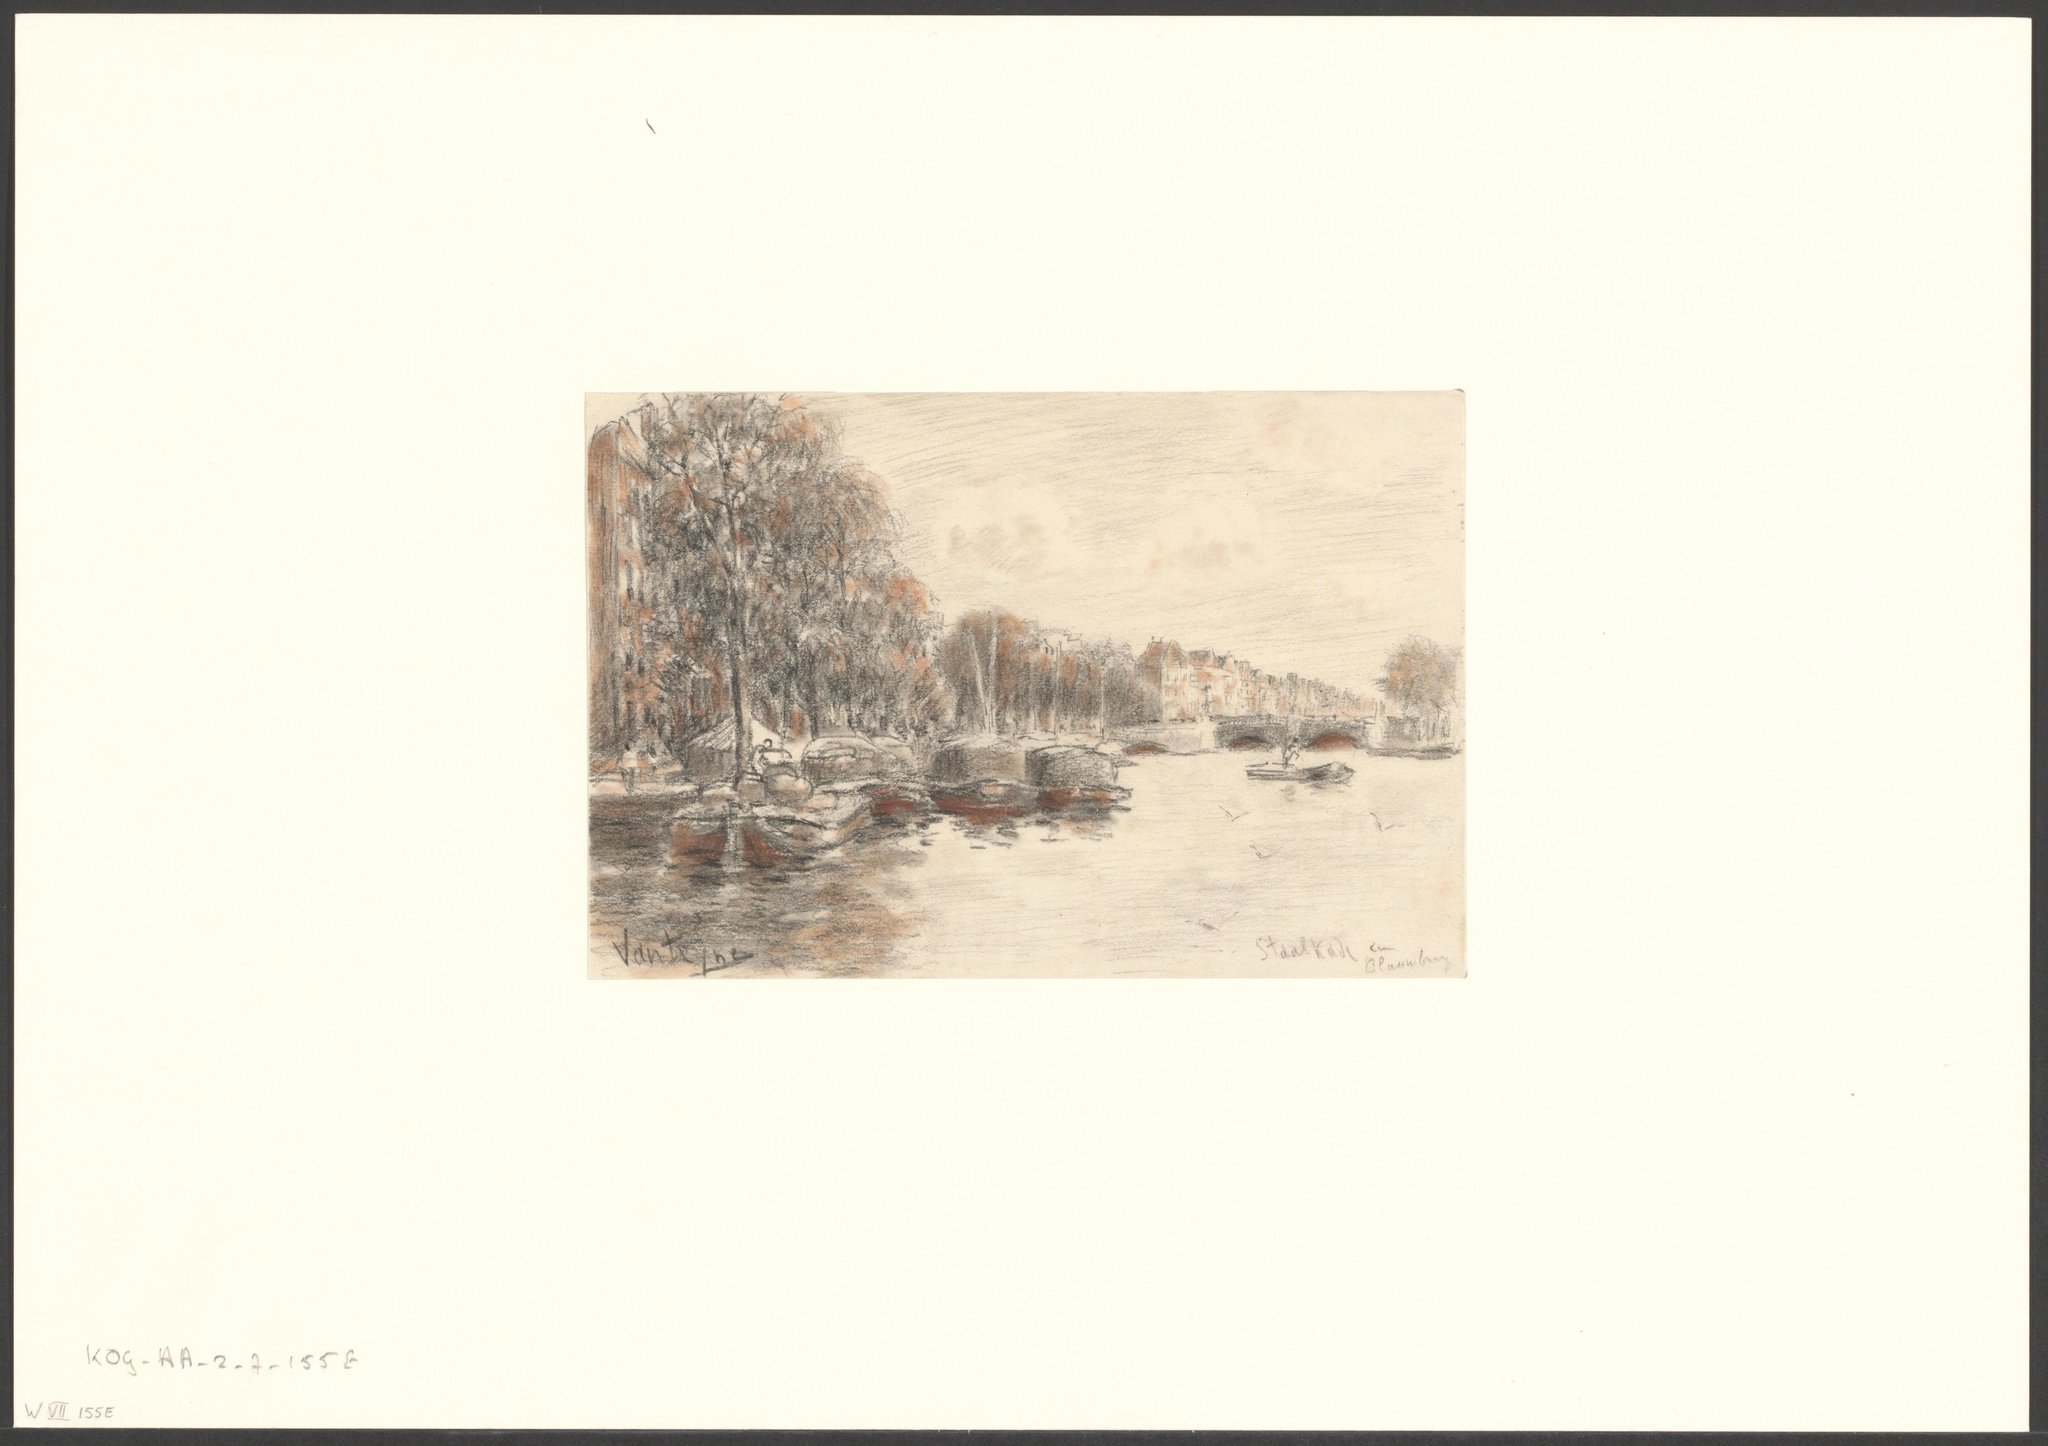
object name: drawing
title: Gezicht op de Amstel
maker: anthonie van teijn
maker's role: draughtsman, painter, print maker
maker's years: 1863-1943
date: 1873-1943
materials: chalk, paper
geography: amsterdam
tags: river, canal, bridge in city across river, canal, etc., boat propelled by man or animal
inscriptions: inscription: ‘Staalkade en / Blauwbrug’, signature: ‘VanTeyne’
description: Tekening binnen de Atlas Van Eck ingedeeld op wijknummer 7.